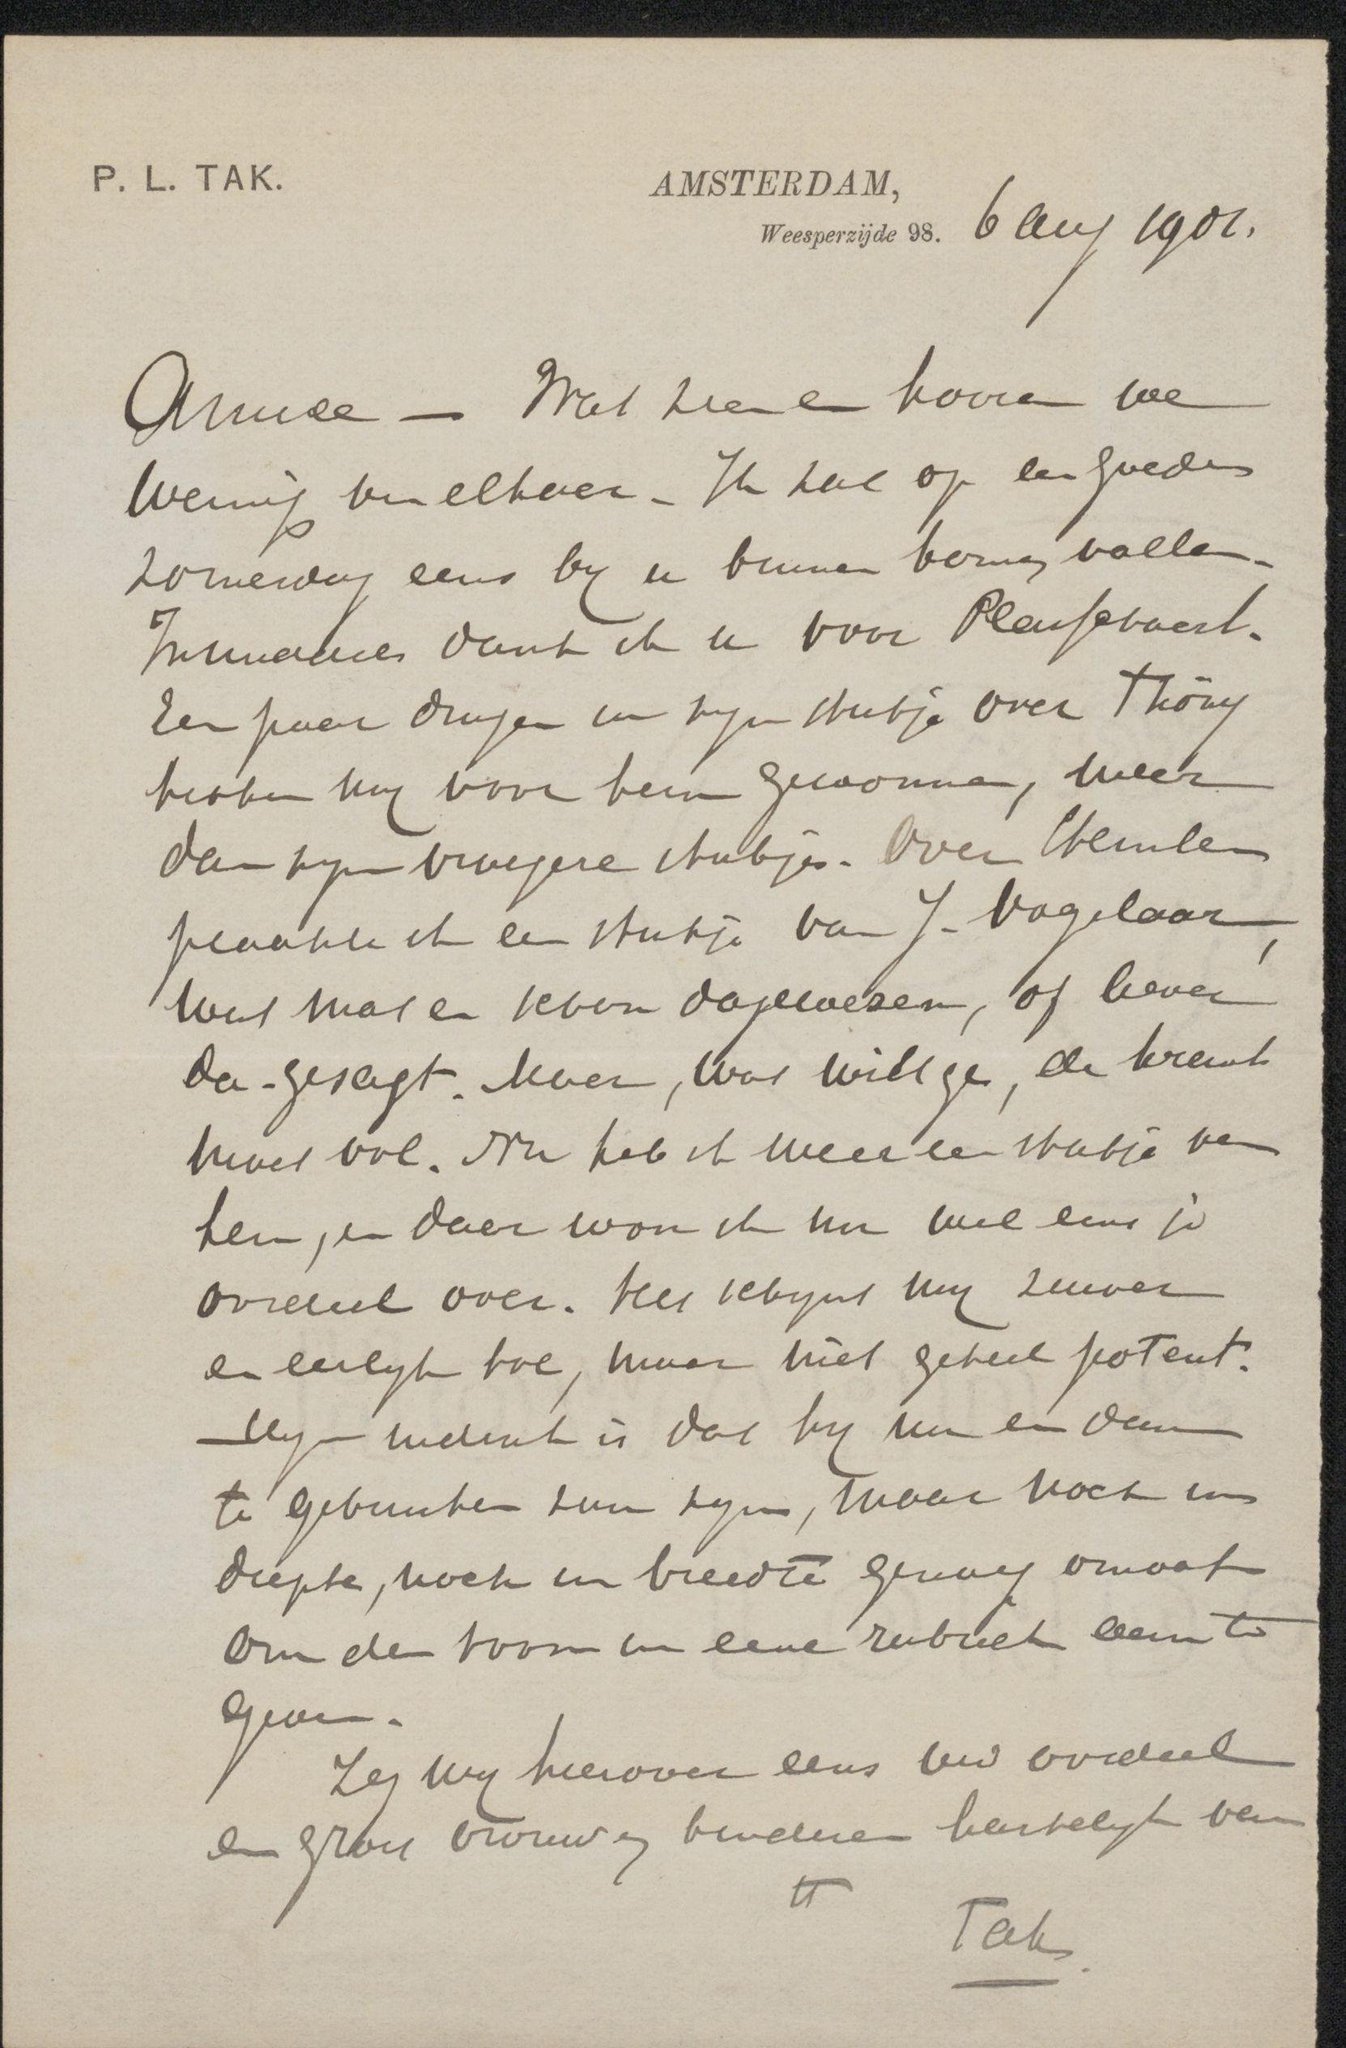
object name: letter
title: Brief aan Jan Veth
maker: pieter lodewijk tak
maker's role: politician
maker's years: 1848-1907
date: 1901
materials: ink, paper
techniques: pen, printing, writing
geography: amsterdam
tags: dordrecht, amsterdam, painter, print maker, draughtsman, designer, jan veth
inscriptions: watermark, collector's mark: ‘RPK’